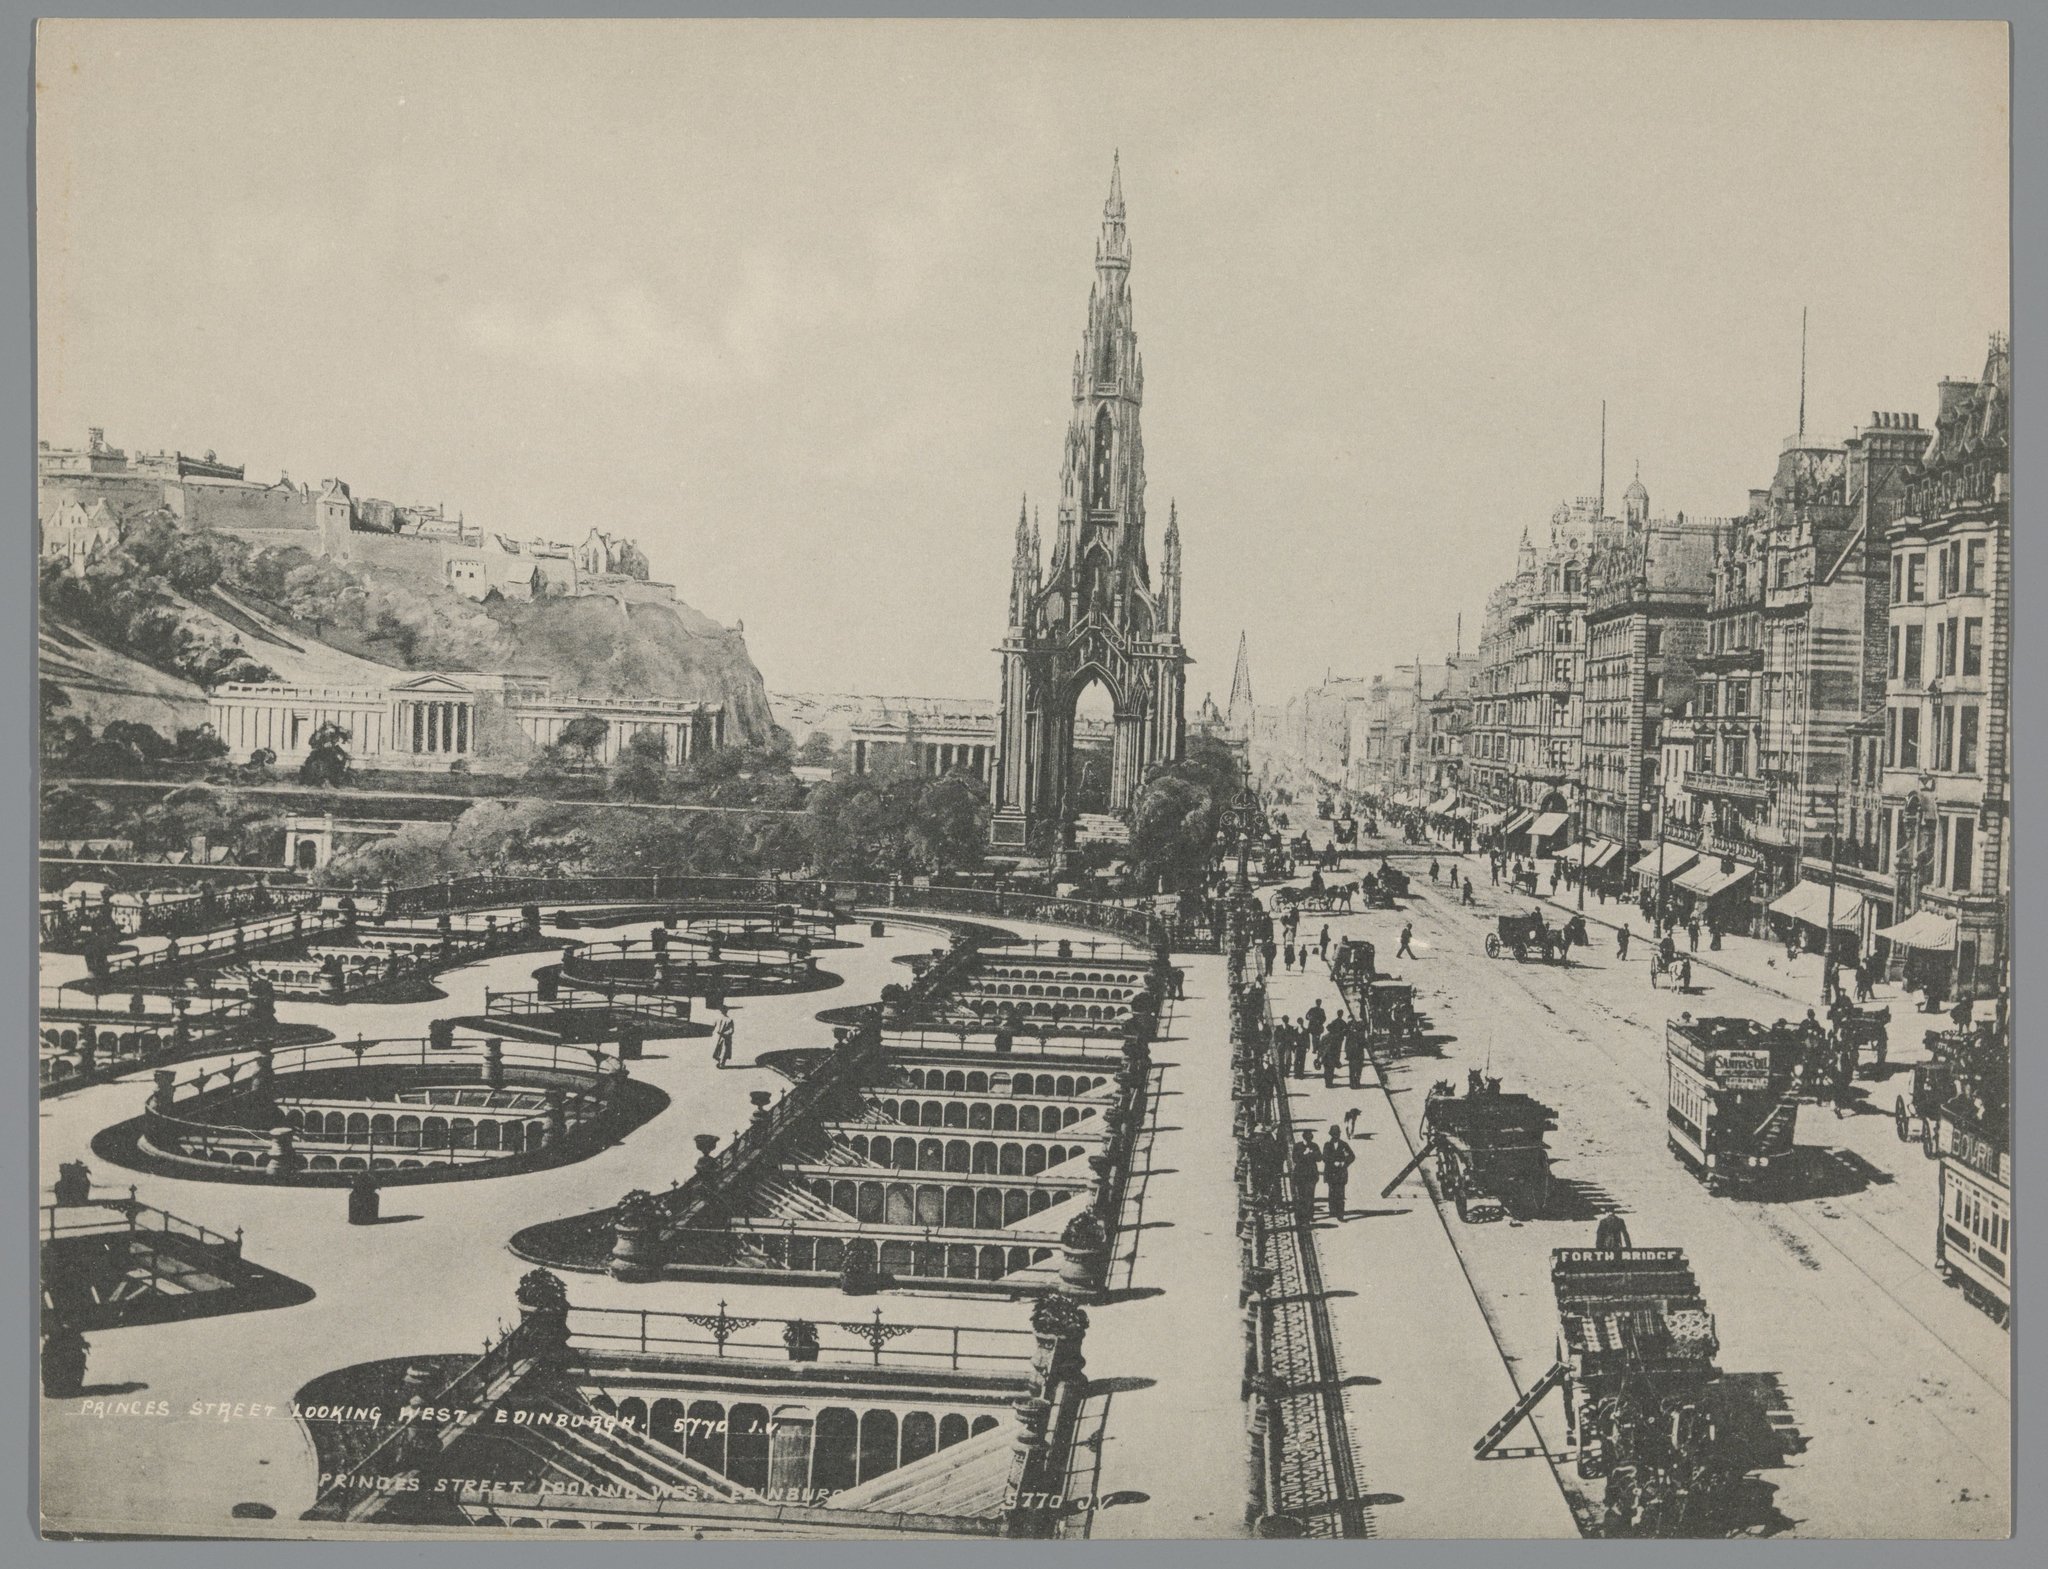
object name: print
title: Stadsgezicht van Edinburgh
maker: Anonymous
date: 1860-1915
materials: paper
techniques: photograph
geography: united kingdom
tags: edinburgh